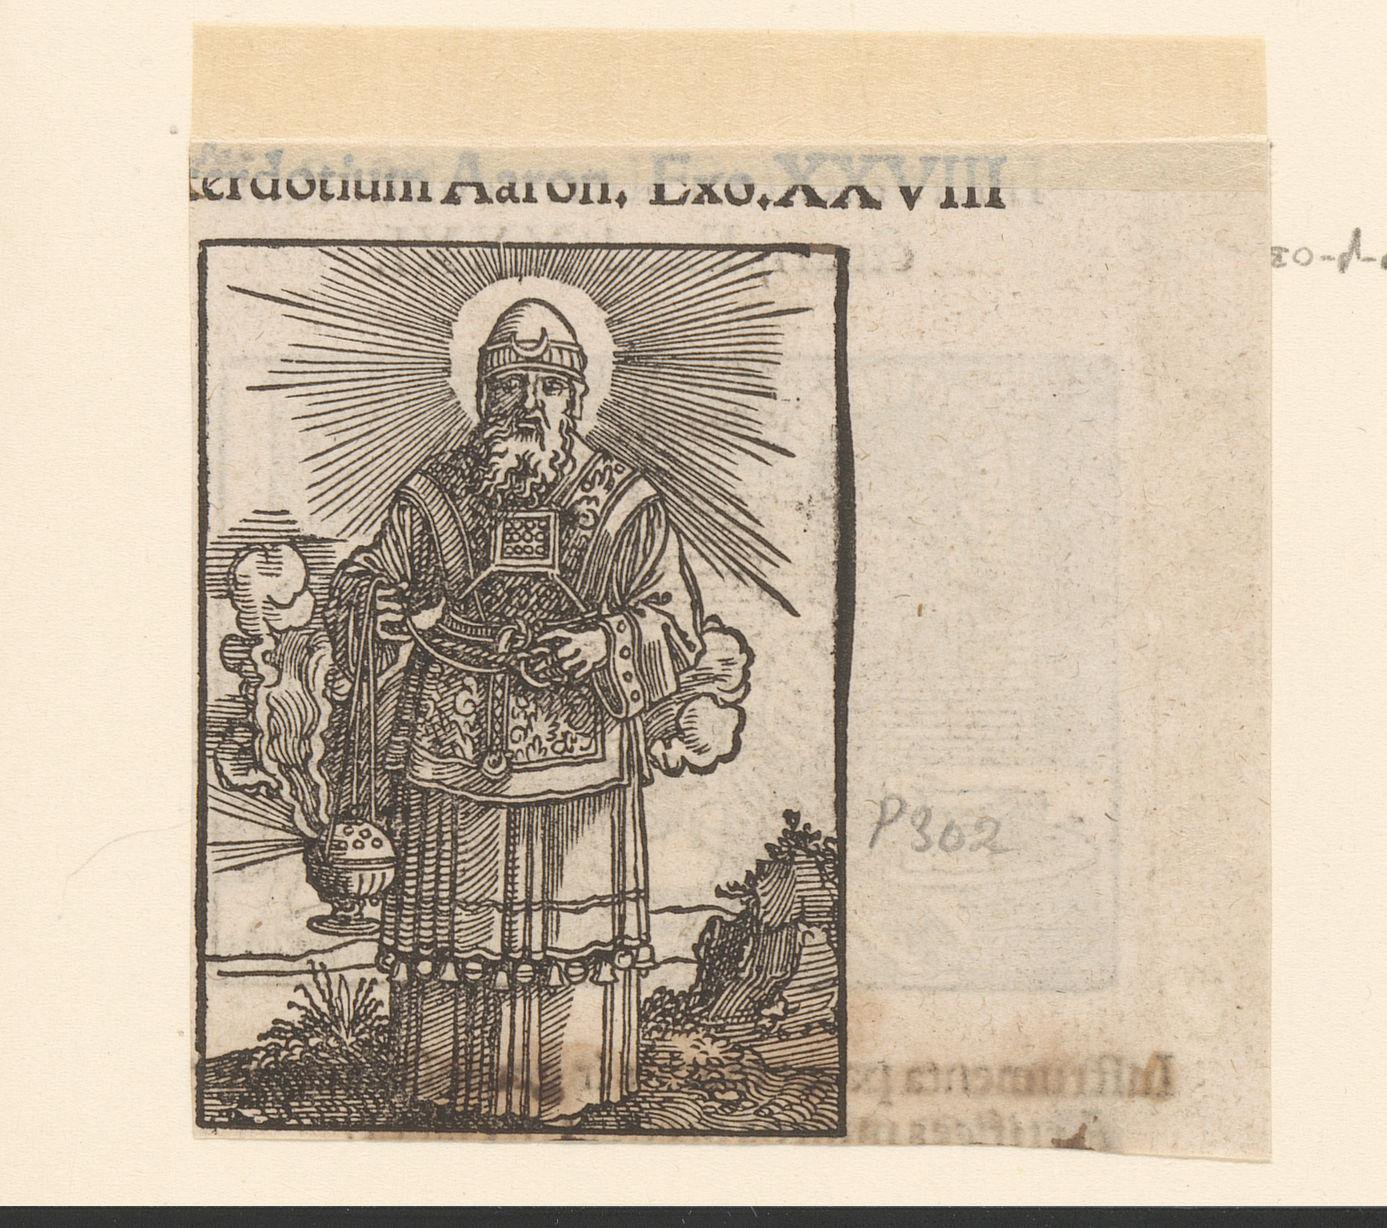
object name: print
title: Aäron in het gewaad van hogepriester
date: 1530-1533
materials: paper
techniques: woodcut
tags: aaron (not in biblical context); possible attributes: attributes of aaron: censer, dressed as high priest or bishop, ointment jar, rod or flowering wand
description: Prent afkomstig uit: Biblicae historiae. Frankfurt am Main: Egenloph, 1539.